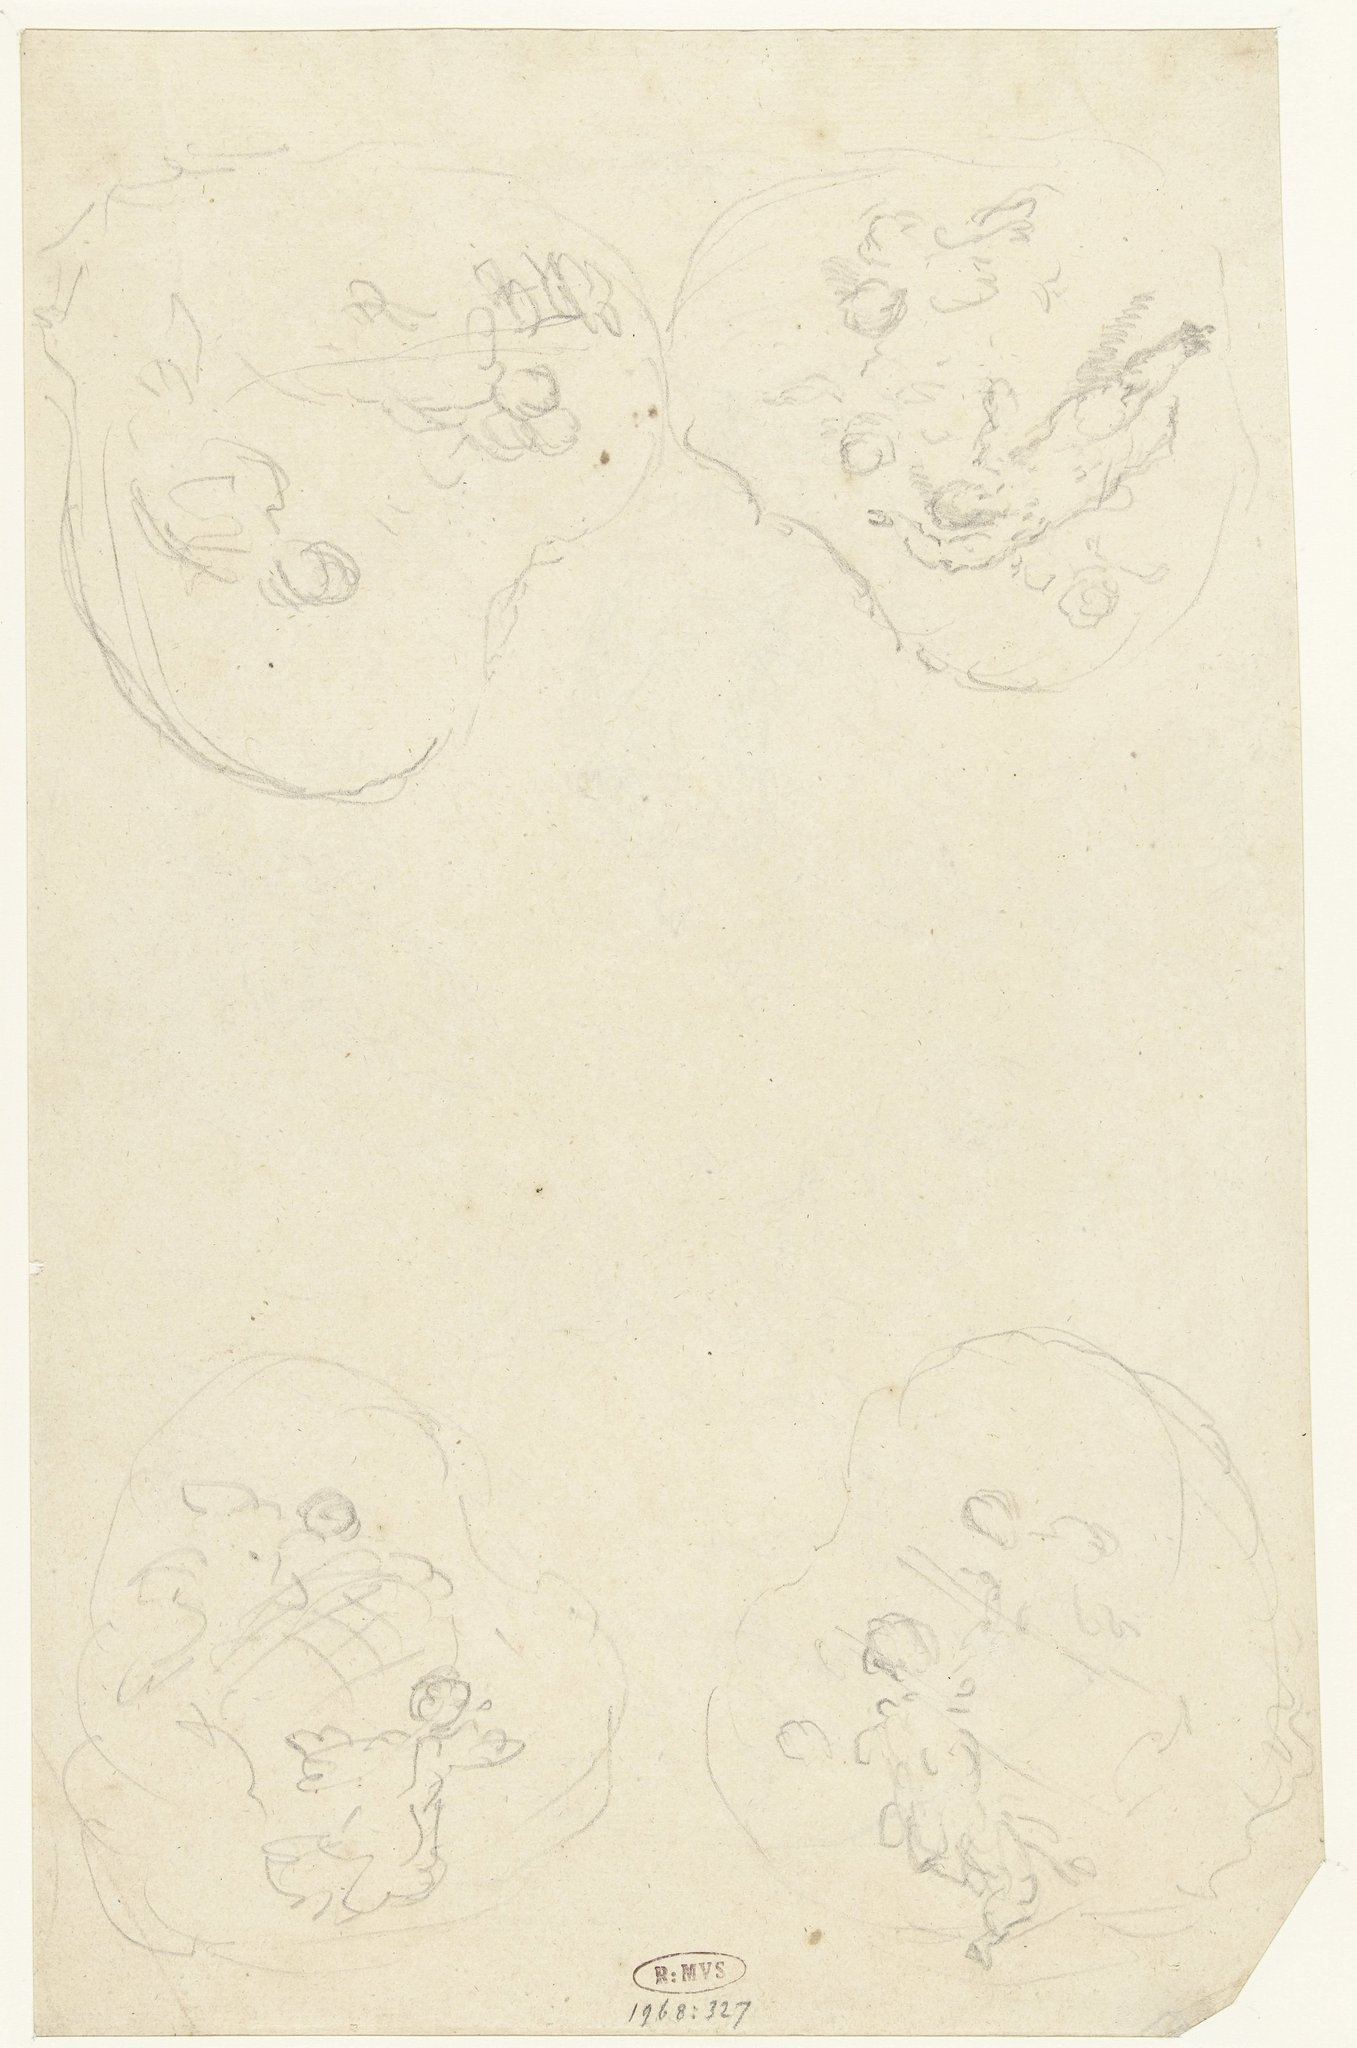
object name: drawing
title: Ontwerp voor de vier hoekornamenten van een plafondschildering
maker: dionys van nijmegen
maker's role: draughtsman, painter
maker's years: 1705-1798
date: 1715-1798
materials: paper, pencil